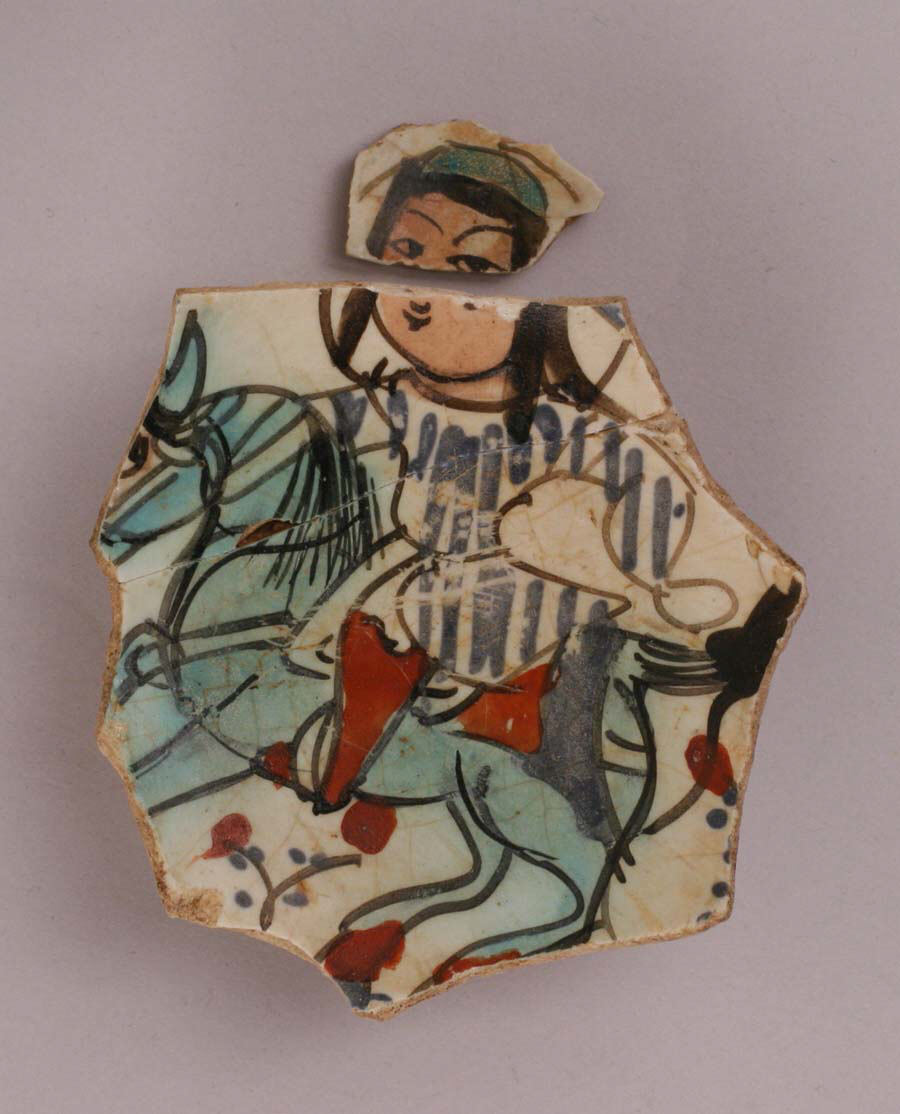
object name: fragment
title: Fragment of a Bowl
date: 1101-1300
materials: stonepaste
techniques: overglaze, painting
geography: iran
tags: human figures